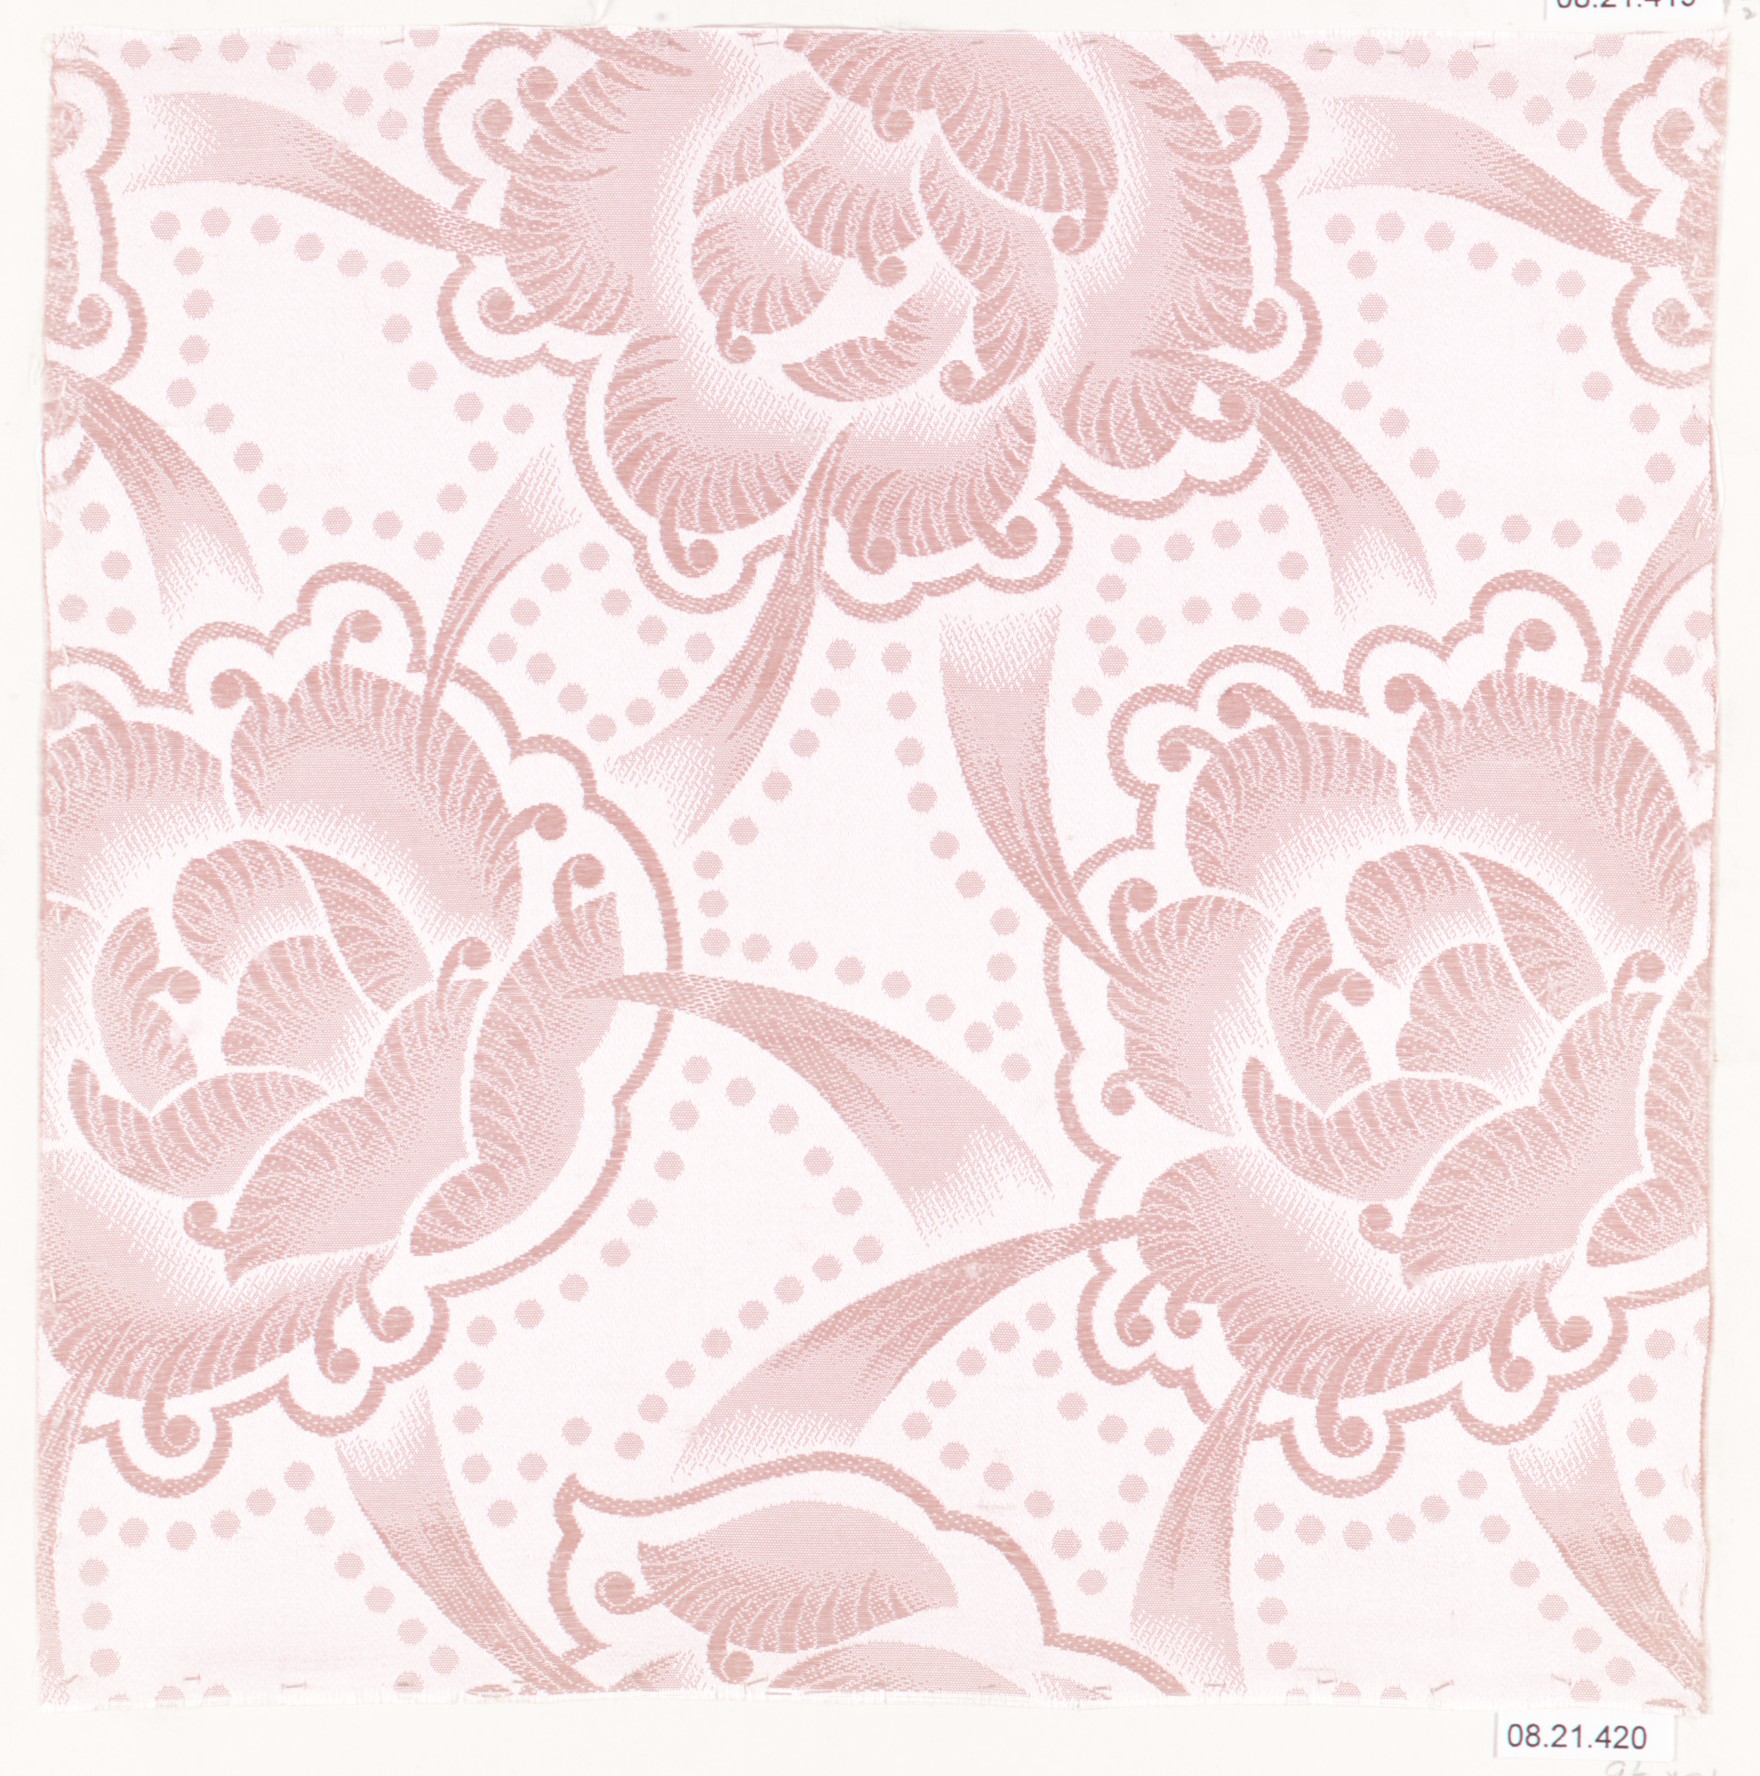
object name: textile sample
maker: Anonymous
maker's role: designer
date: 1900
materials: silk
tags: flowers